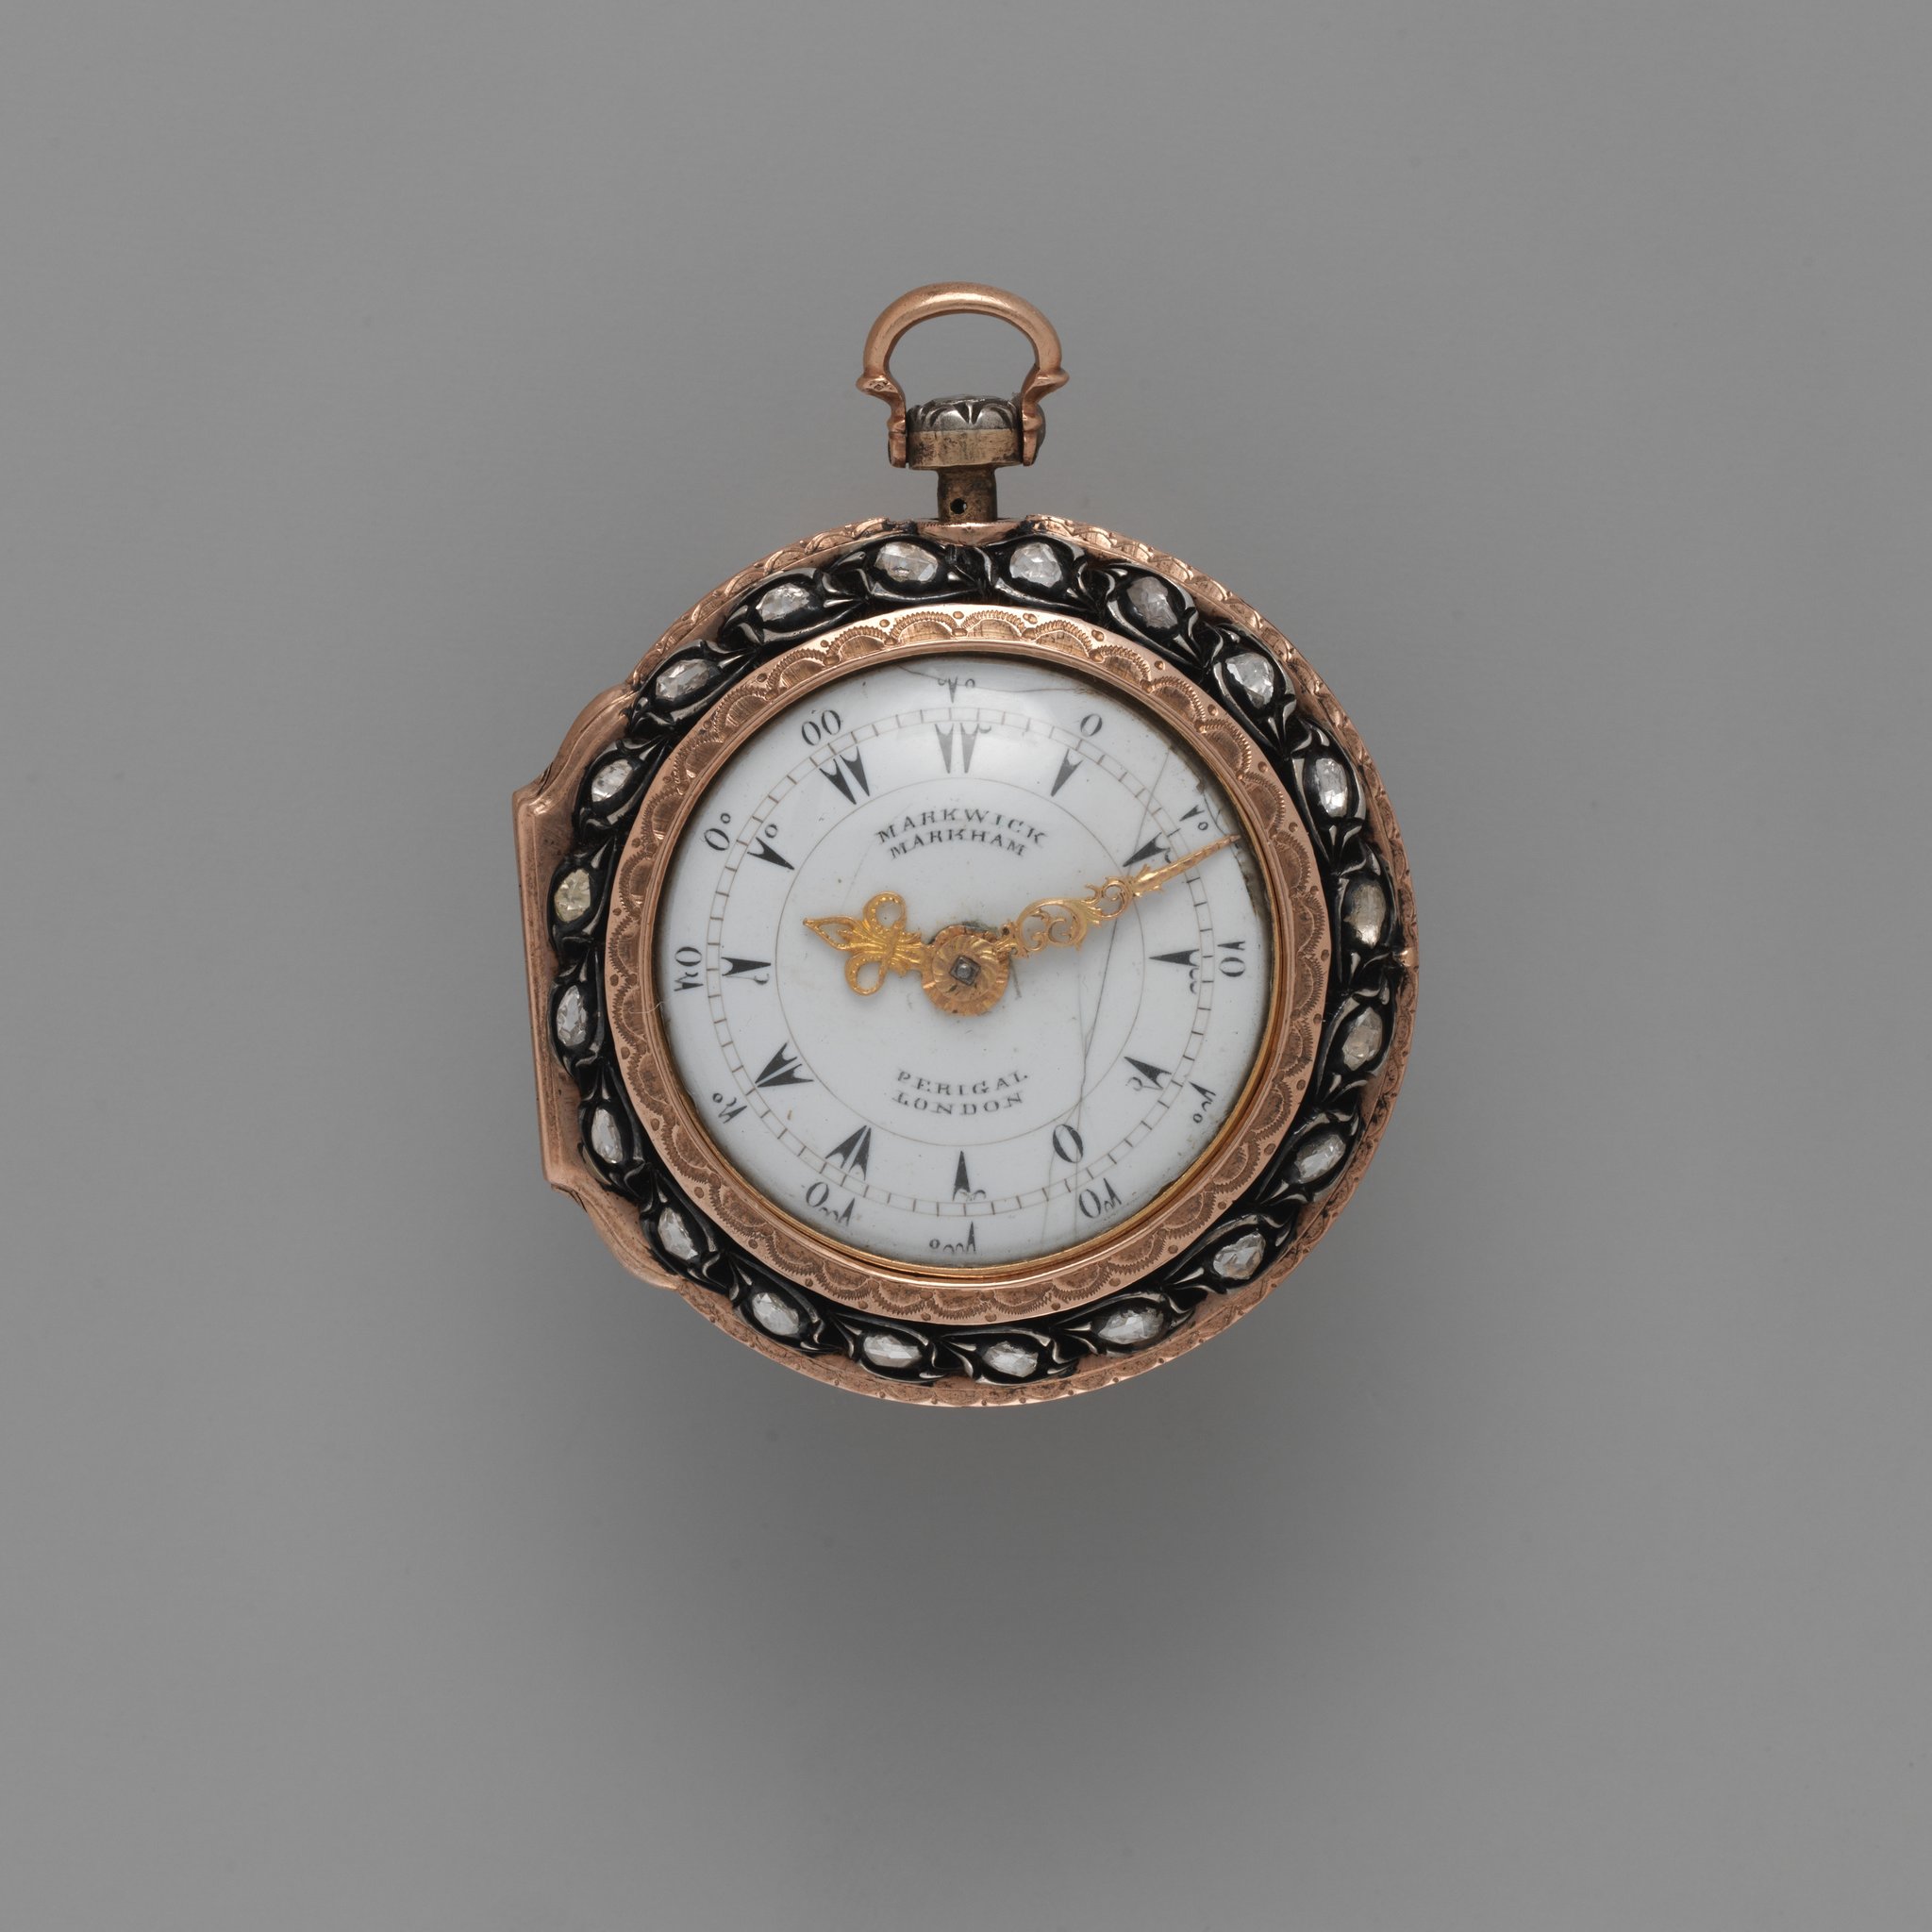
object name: watch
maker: richard peckover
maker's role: maker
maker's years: 1737-1756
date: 1750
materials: diamond, gold